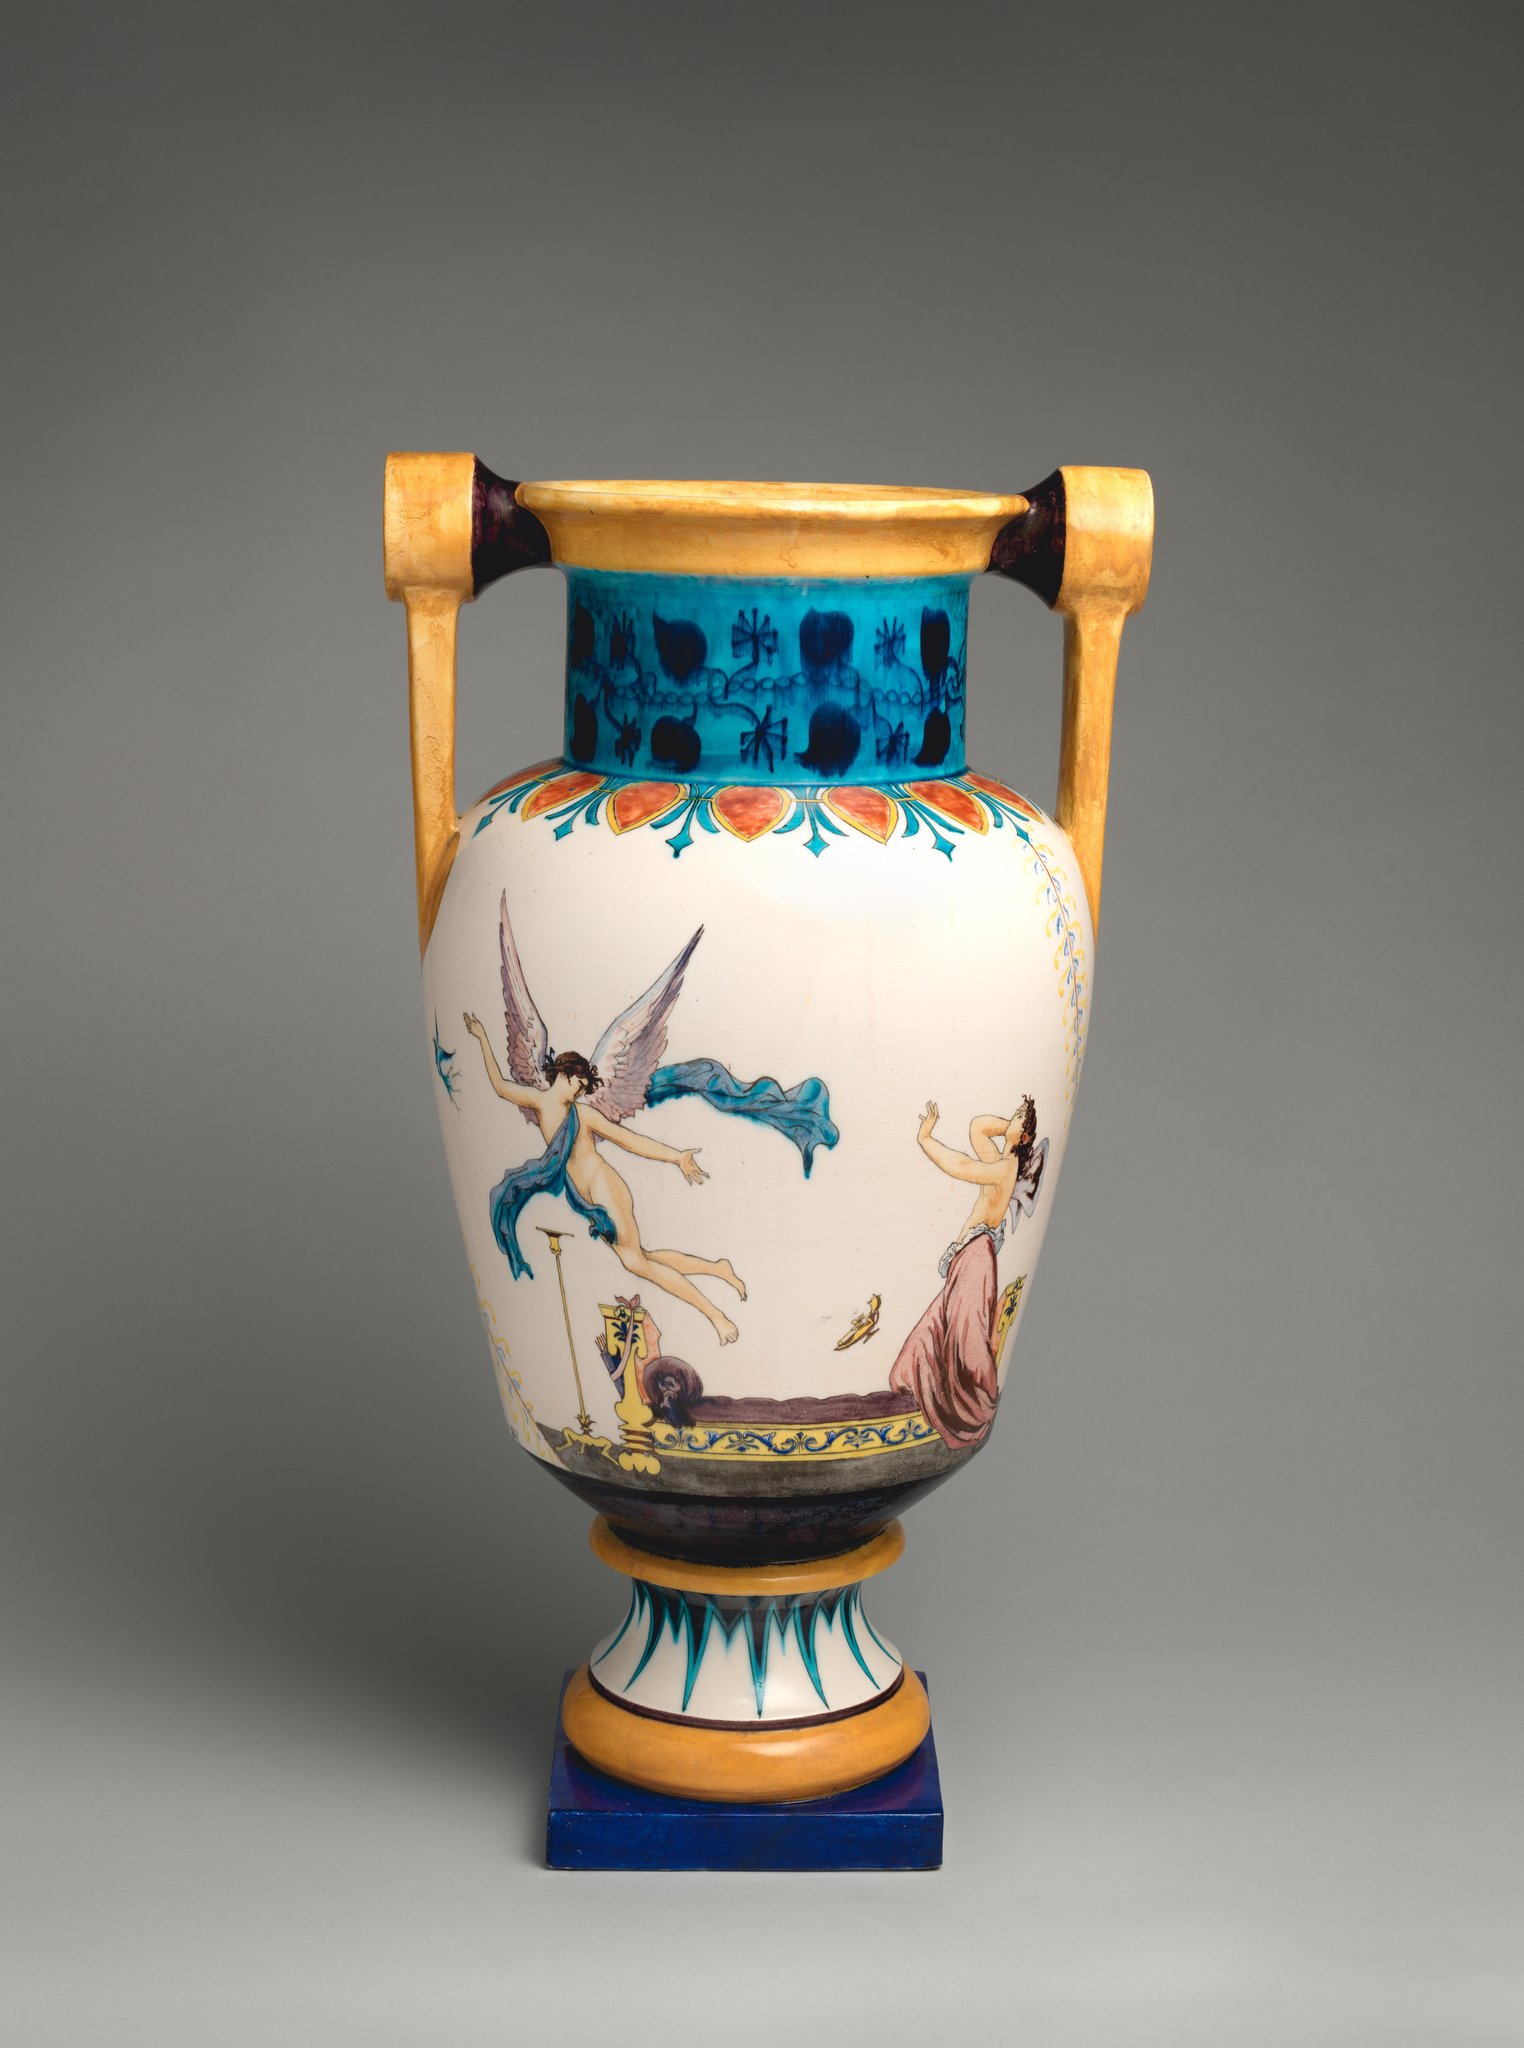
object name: vase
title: Vase with mythological scenes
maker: joseph-théodore deck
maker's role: maker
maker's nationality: french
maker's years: 1823-1891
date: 1867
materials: earthenware